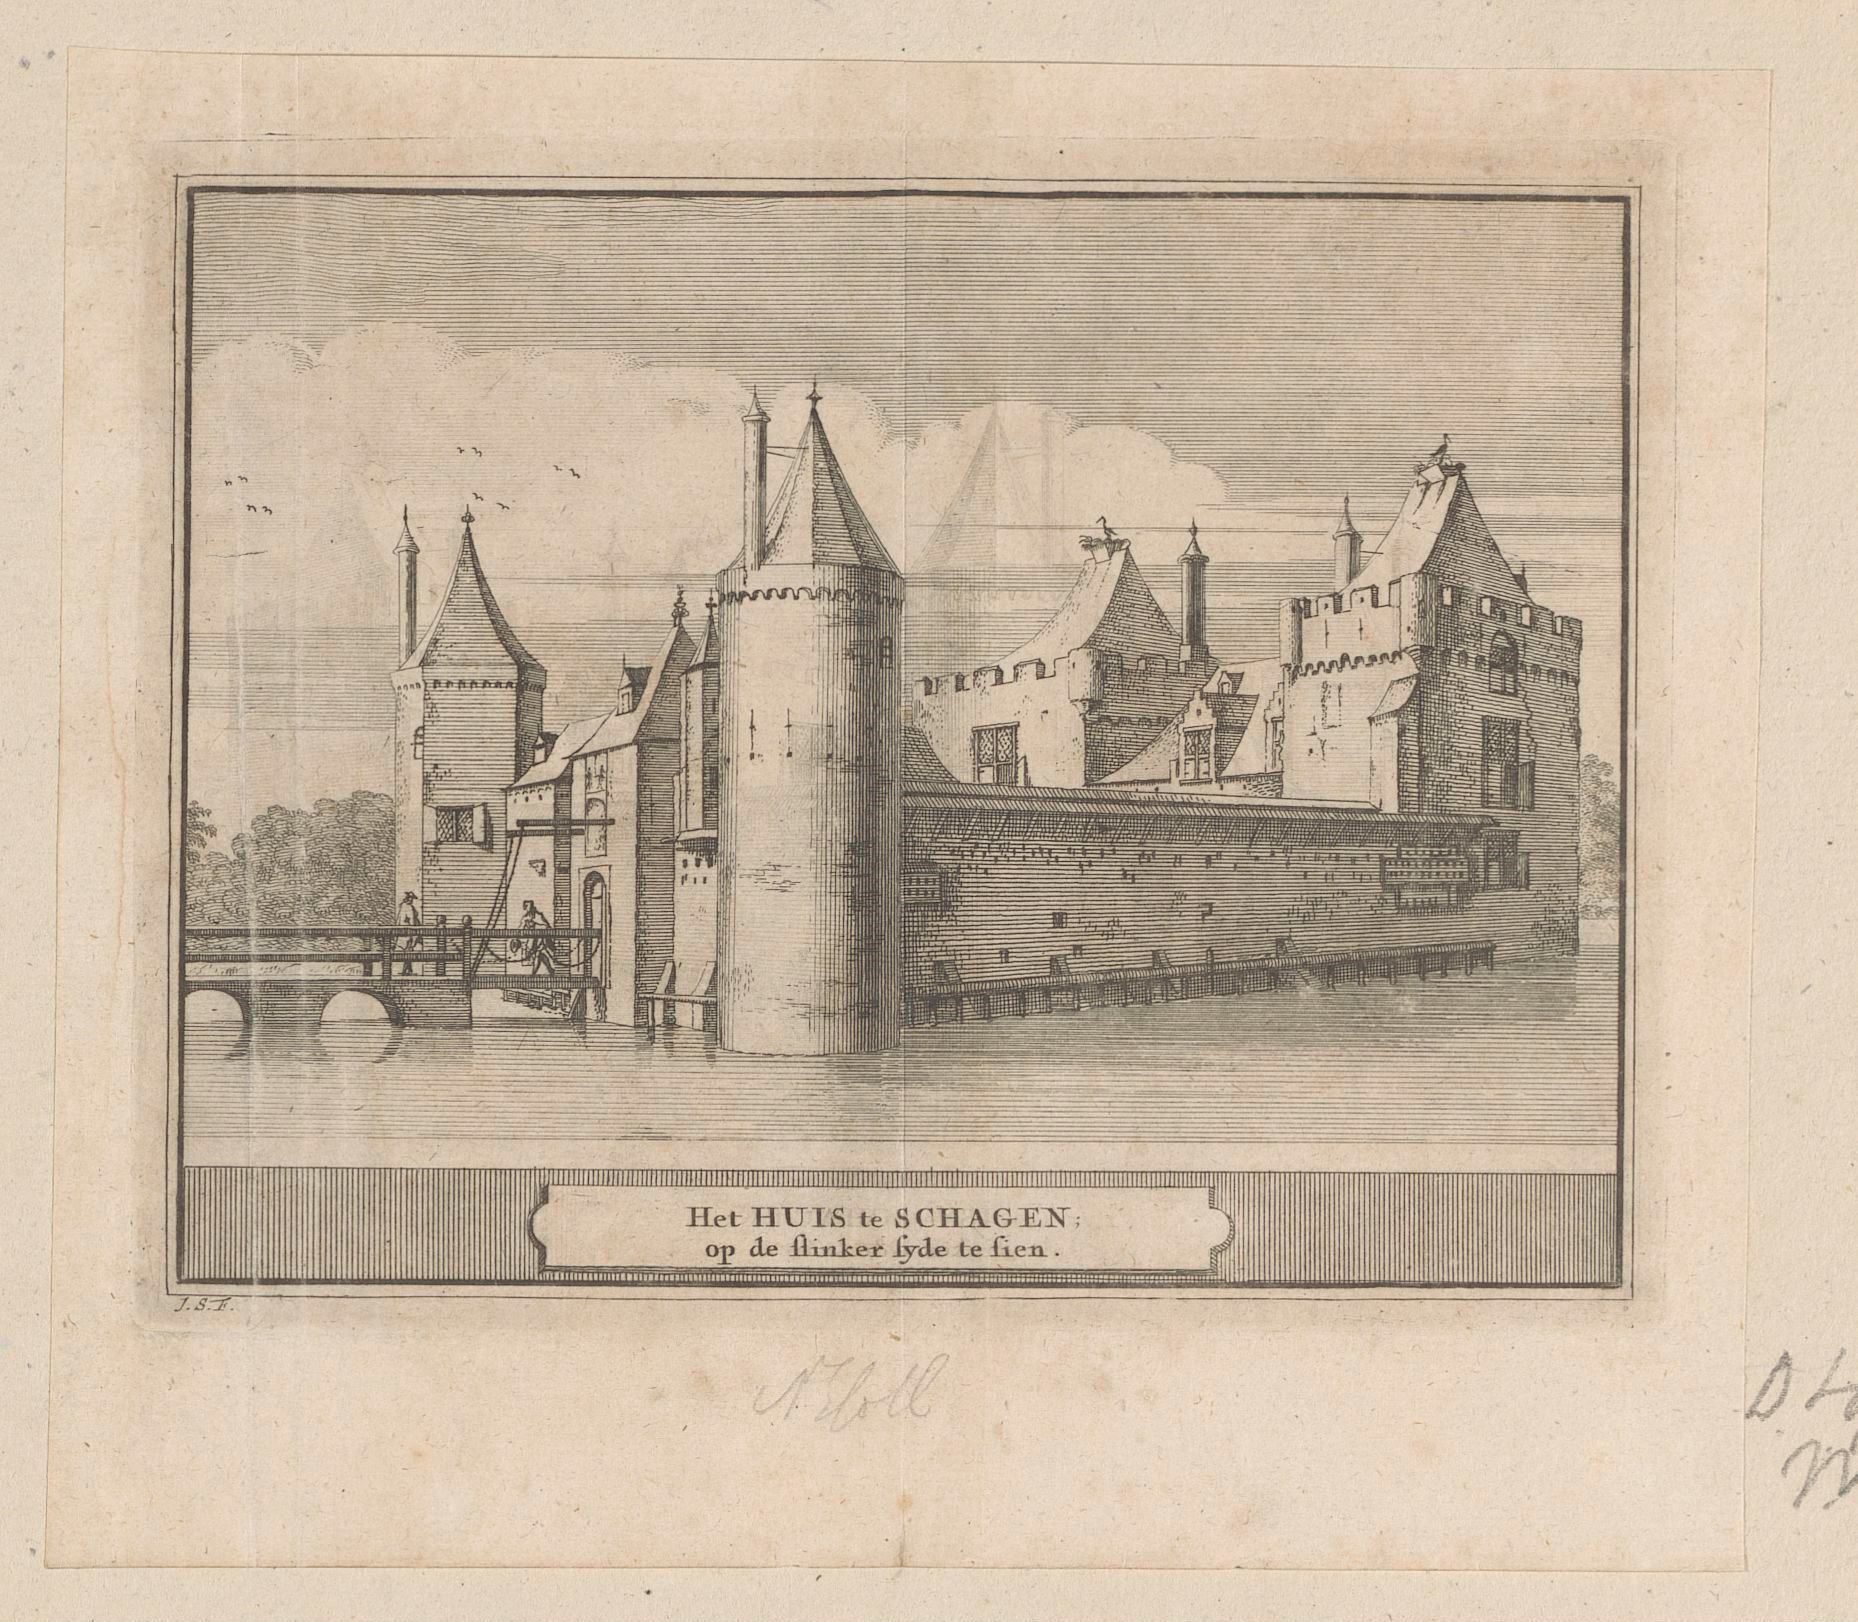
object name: book illustration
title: Gezicht op Huis te Schagen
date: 1711-1774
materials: paper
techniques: engraving, etching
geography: amsterdam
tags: castle, bridge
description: Prent ook gebruikt in: Smids, Ludolf. Schatkamer der Nederlandsse oudheden; of woordenboek, behelsende Nederlands steden en dorpen, kasteelen, sloten en heeren huysen (…). Amsterdam: Pieter de Coup, 1711, tussen p. 306 en 307. Het is ook mogelijk dat deze prent uit de tweede (1737) of derde (1774) druk komt, of uit een uitgave met alleen de prenten: Nederlandsche oudheden, bestaande in zestig verbeeldingen (...) gelegen in Holland, 't Sticht van Utrecht en Gelderland enz. Amsterdam: Hendrik Bosch, 1721.